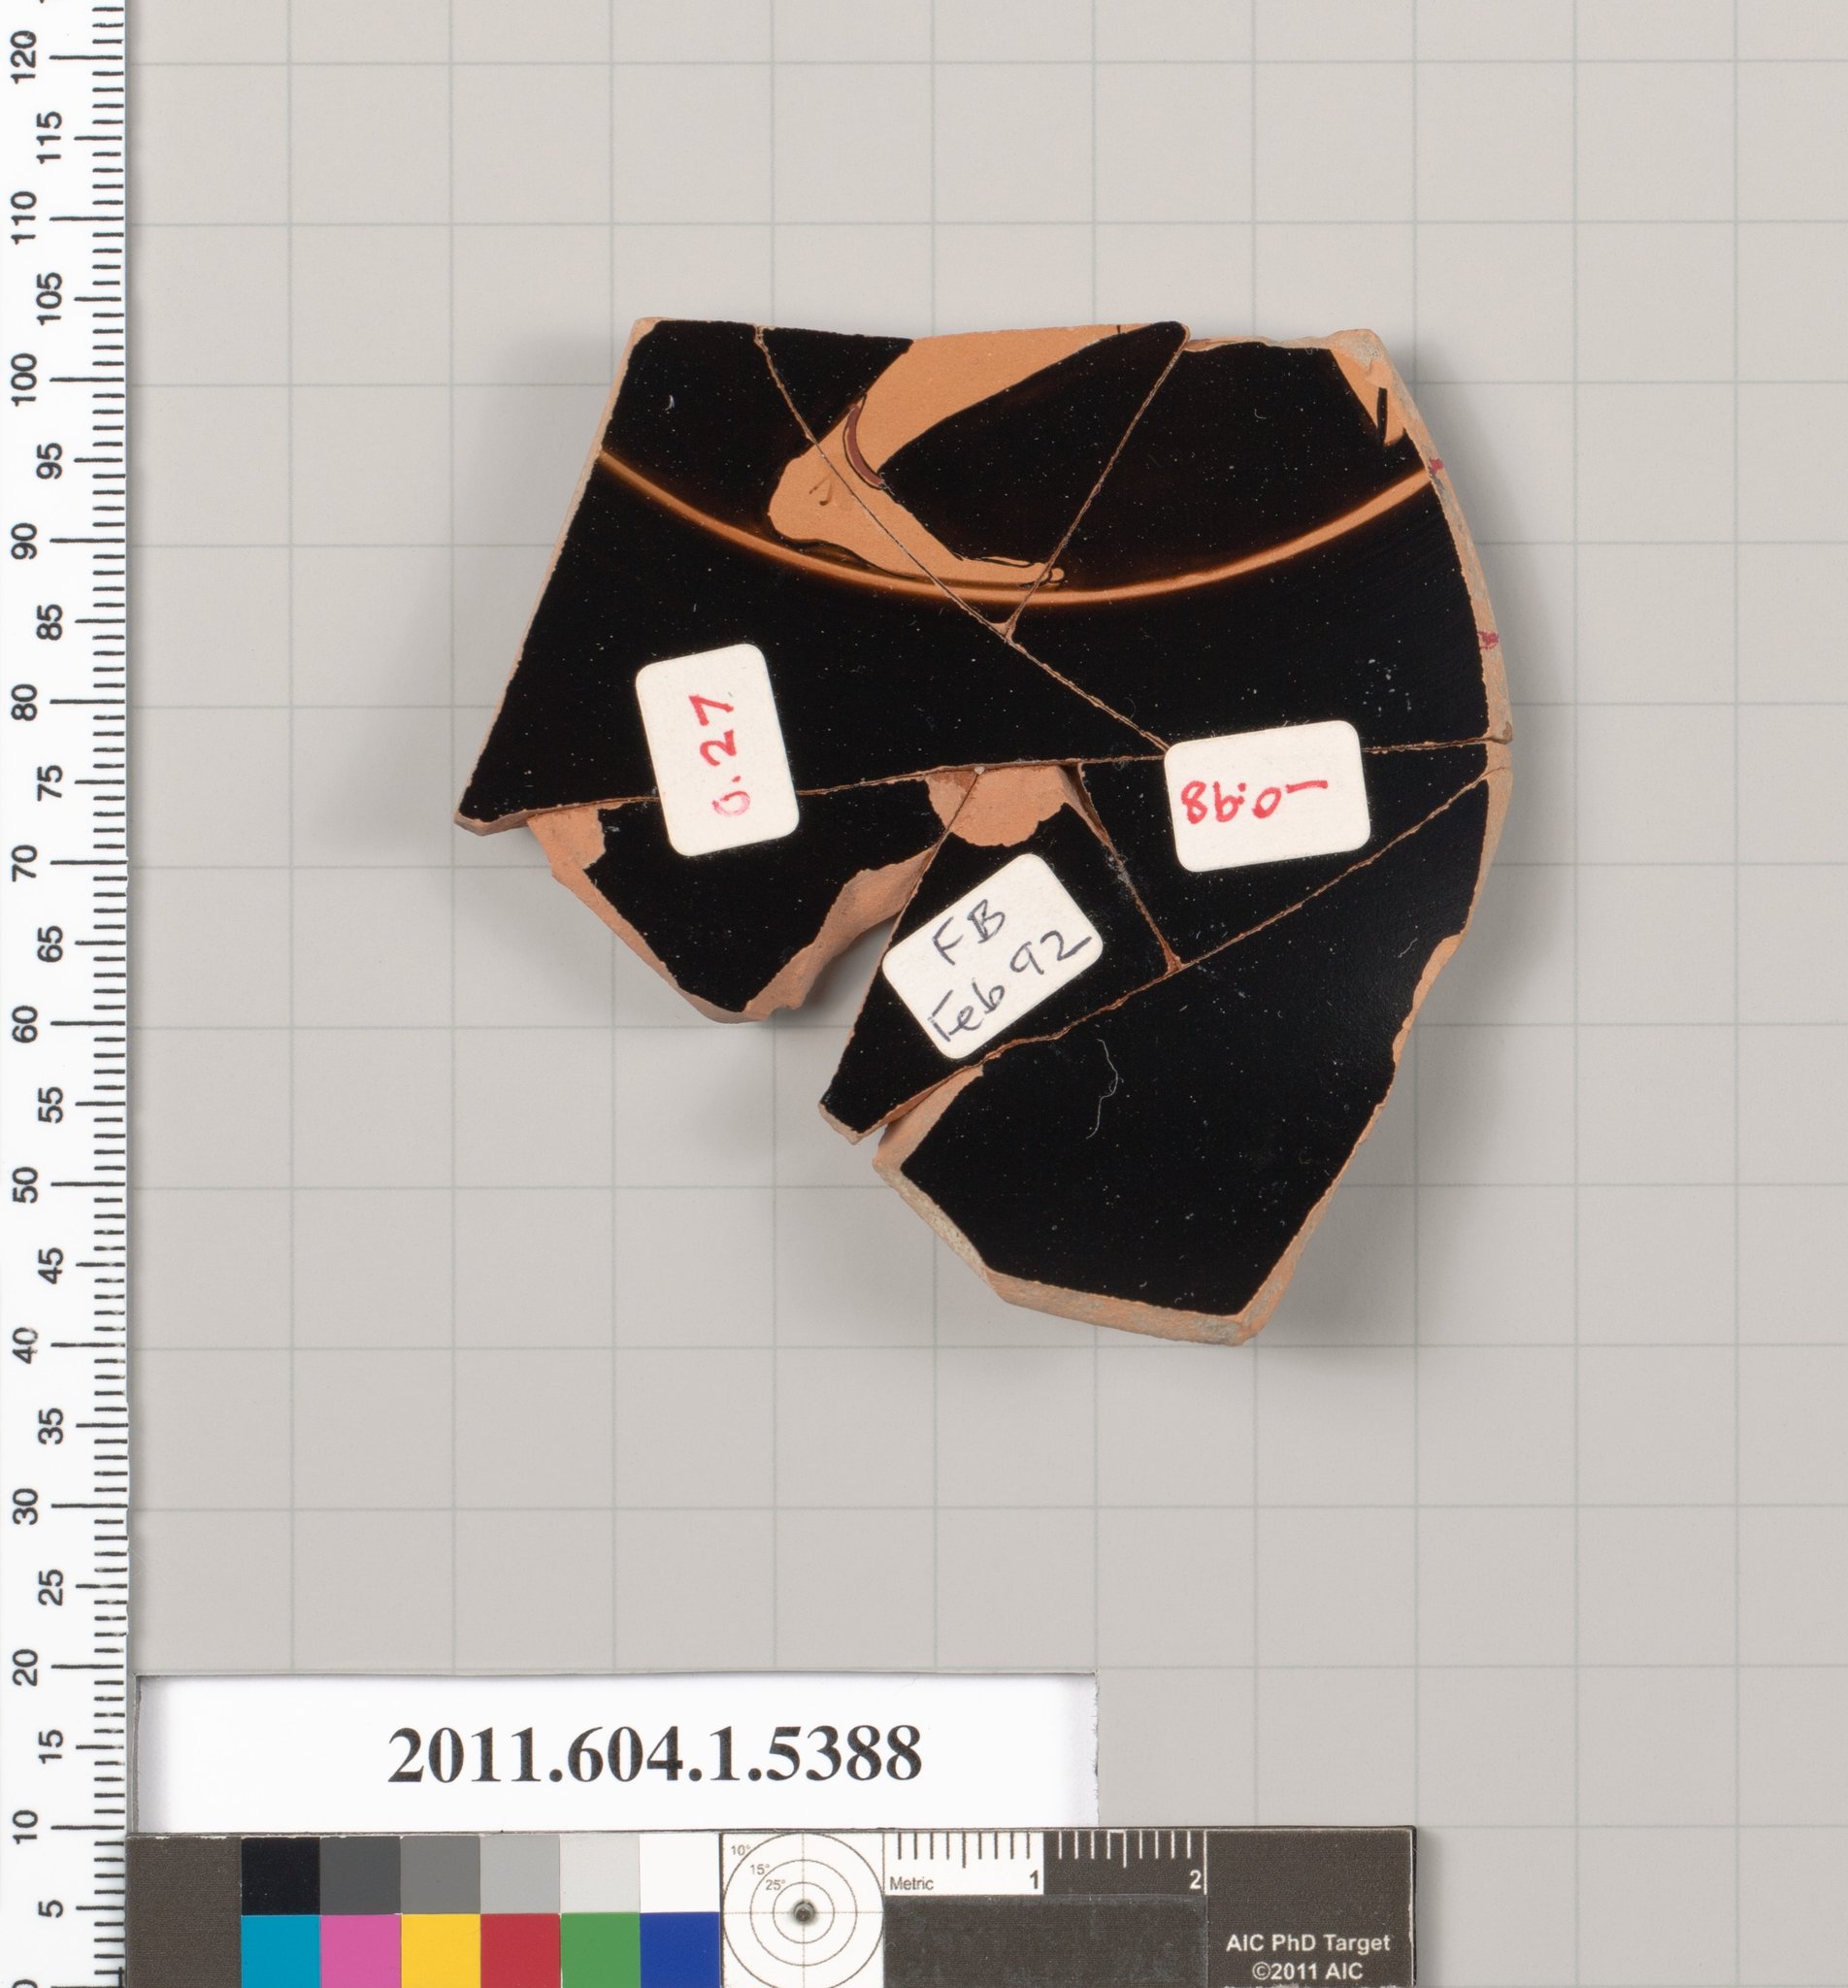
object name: kylix fragment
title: Terracotta fragment of a kylix (drinking cup)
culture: greek, attic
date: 510-500 BCE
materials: terracotta